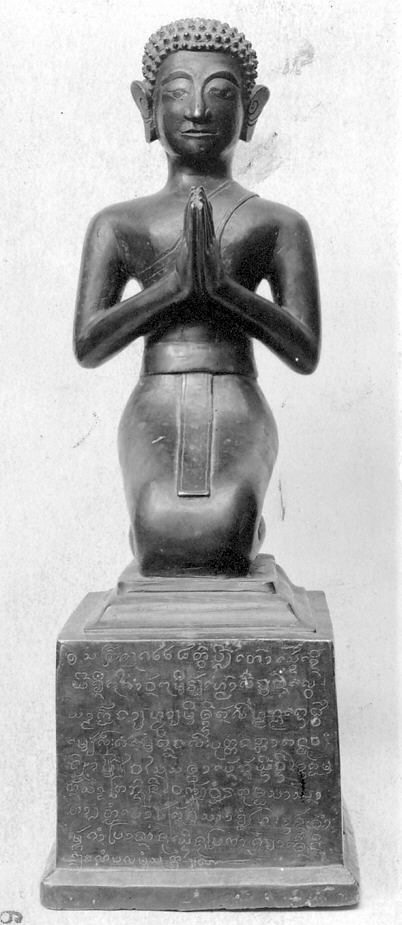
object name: statuette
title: Kneeling Figure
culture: thai or lao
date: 1801-1900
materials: bronze, gilt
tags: men